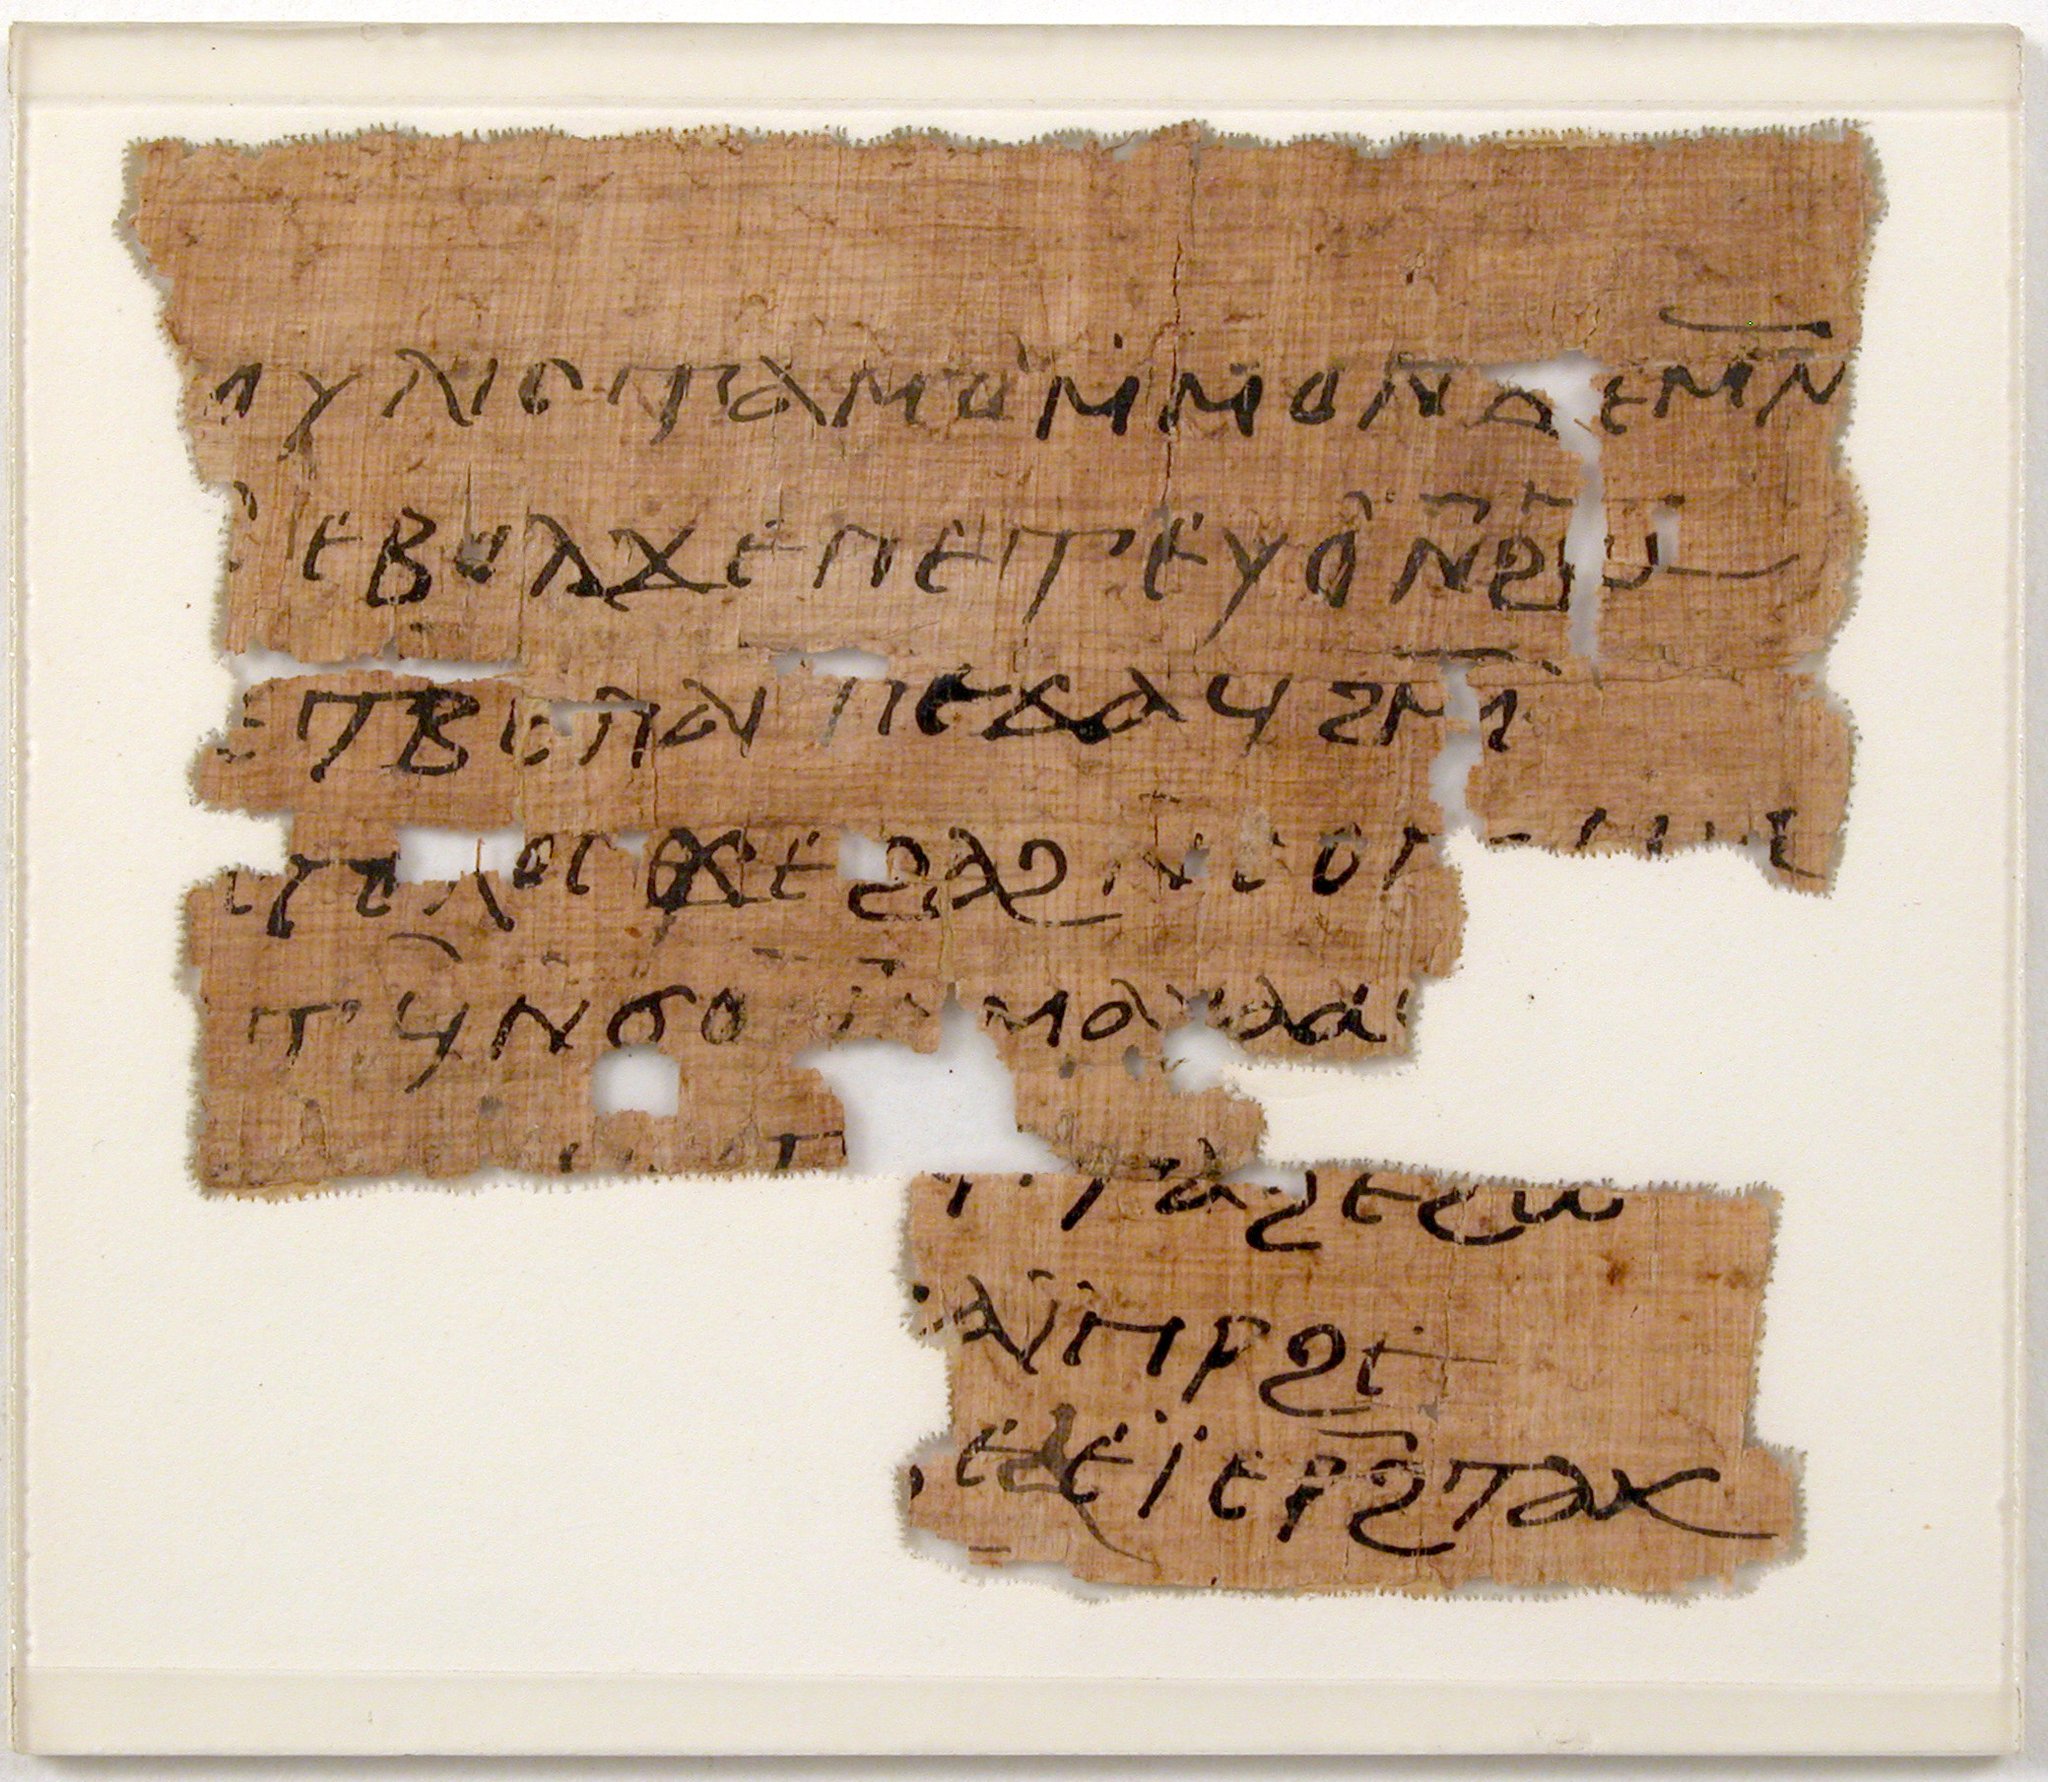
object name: fragment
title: Papyrus Fragment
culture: coptic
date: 601-700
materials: ink, papyrus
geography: egypt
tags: coptic,documents